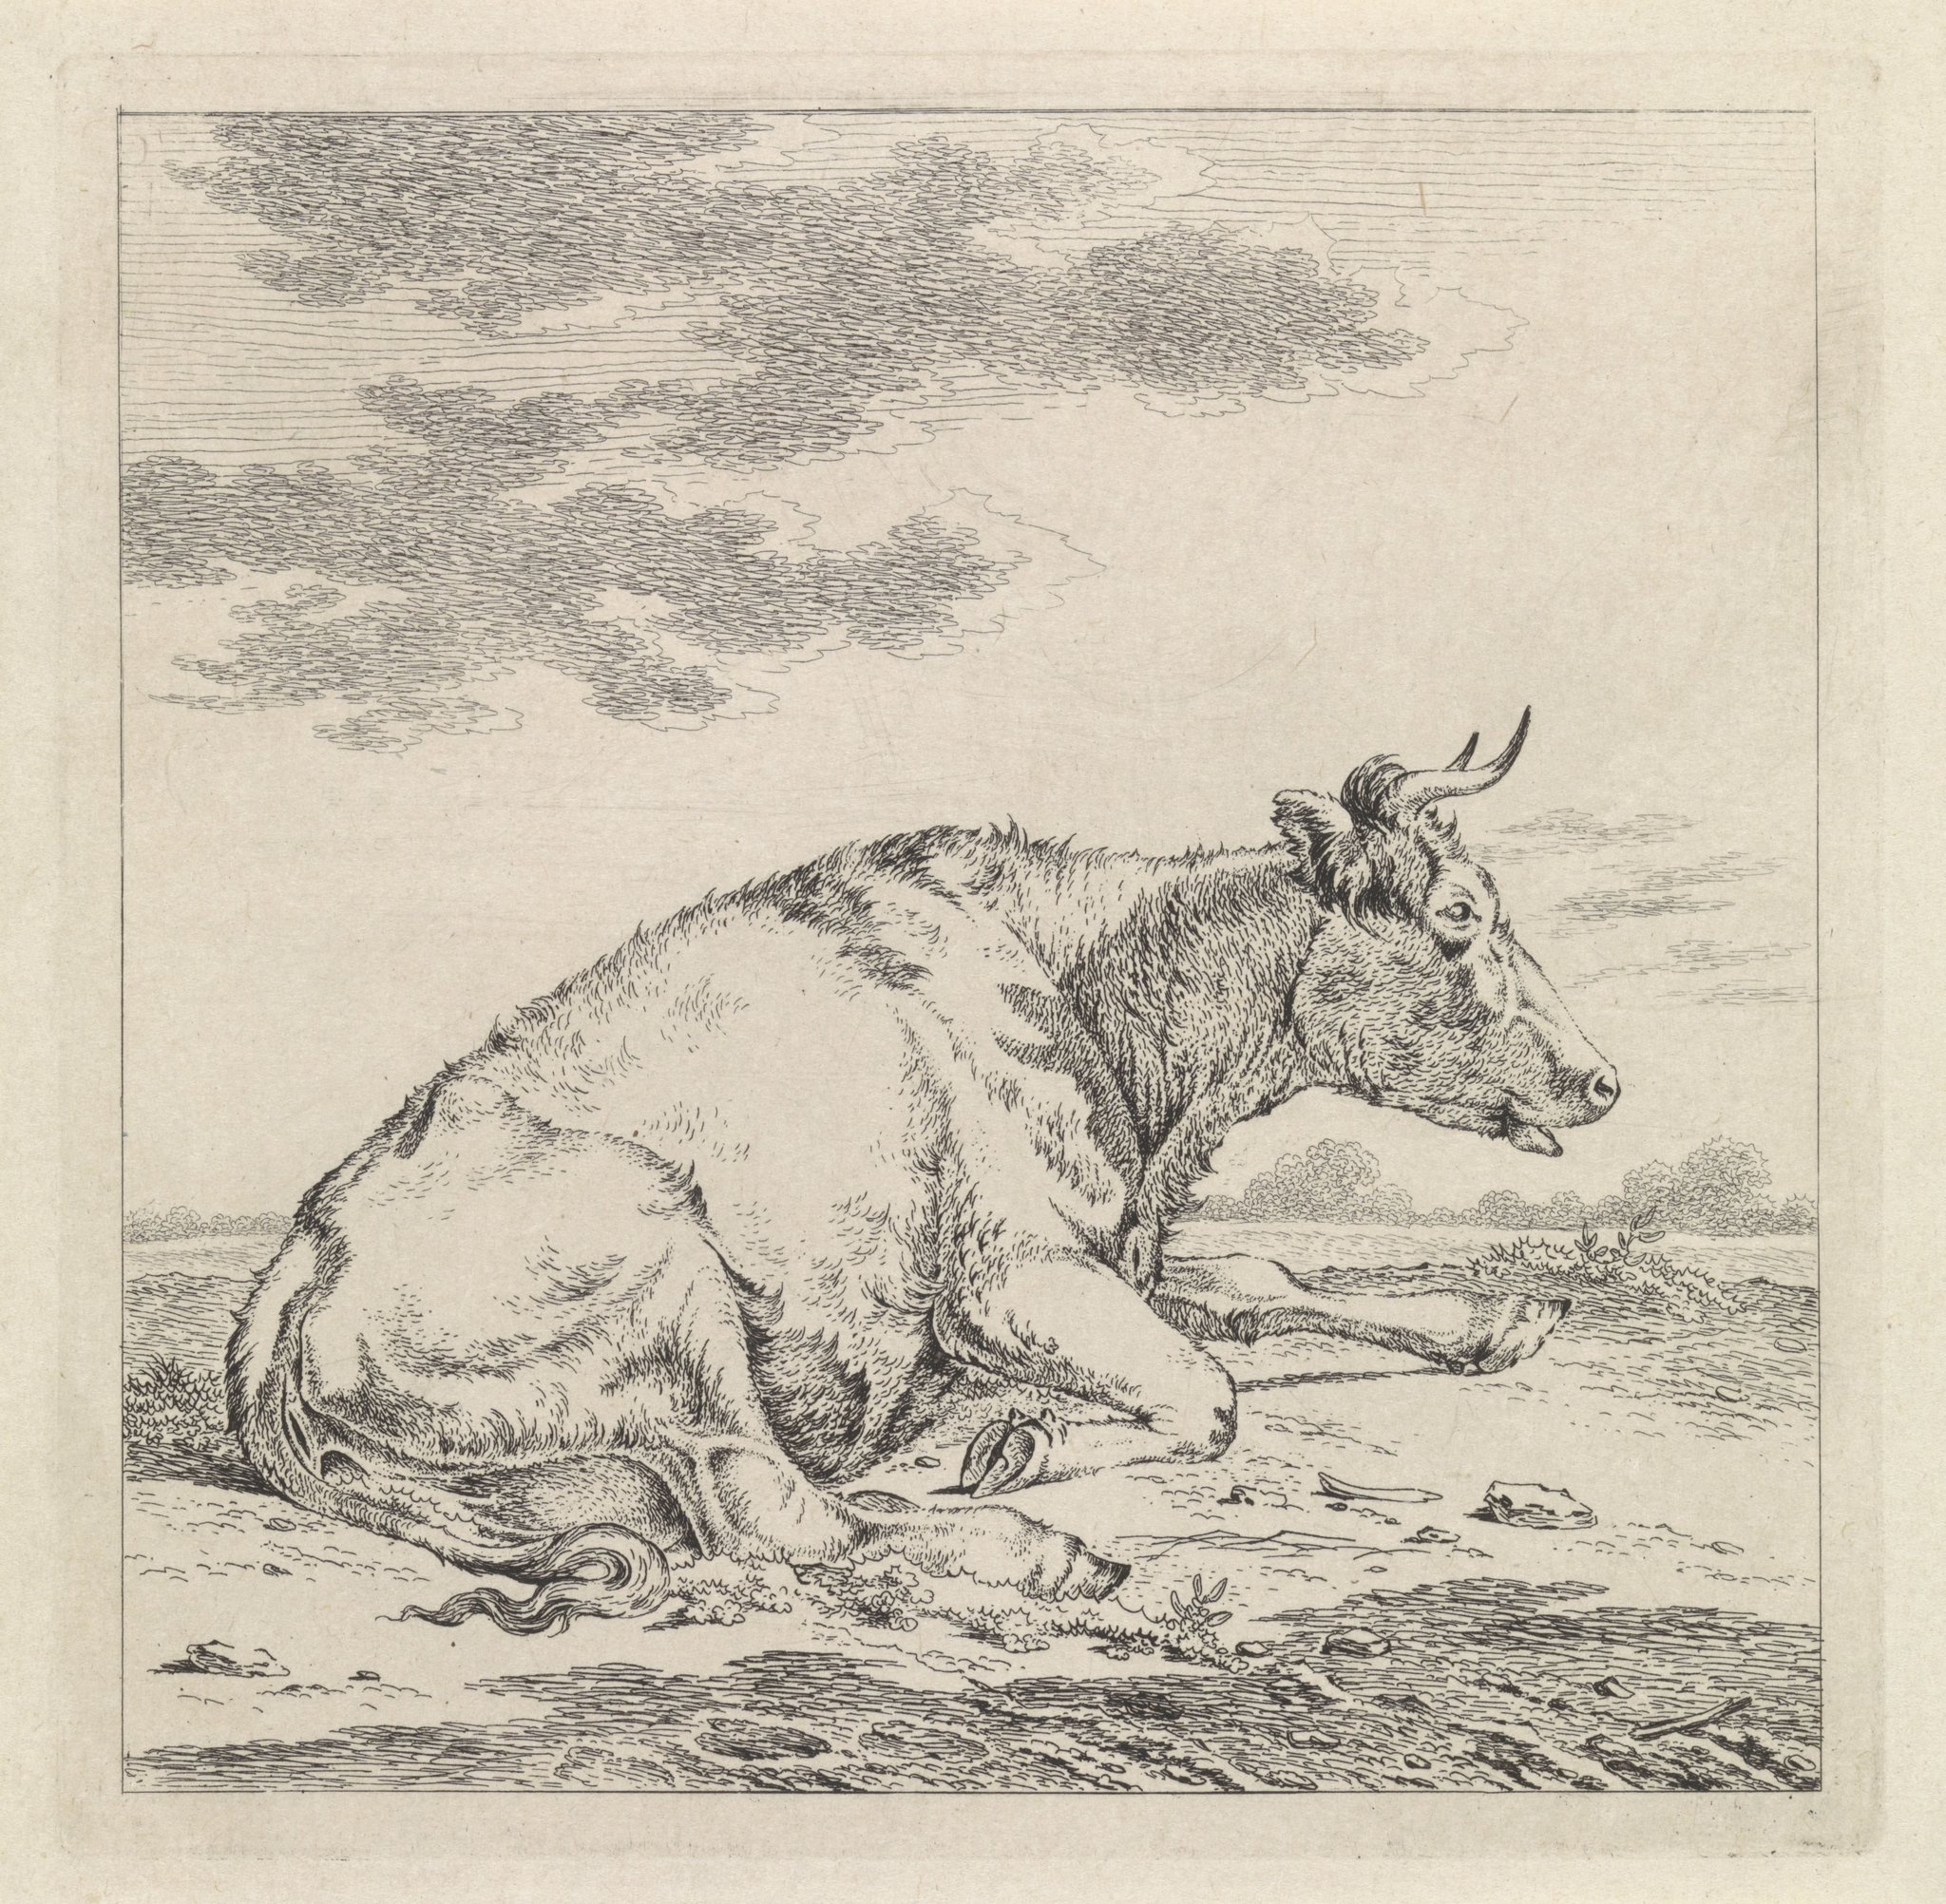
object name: print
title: Liggende koe, naar rechts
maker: pieter janson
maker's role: draughtsman, print maker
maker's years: 1765-1851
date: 1780-1851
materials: paper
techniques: etching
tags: cow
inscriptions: collector's mark: Lugt 2228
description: Landschap met liggende koe, naar rechts. Mét de lucht en achtergrond.